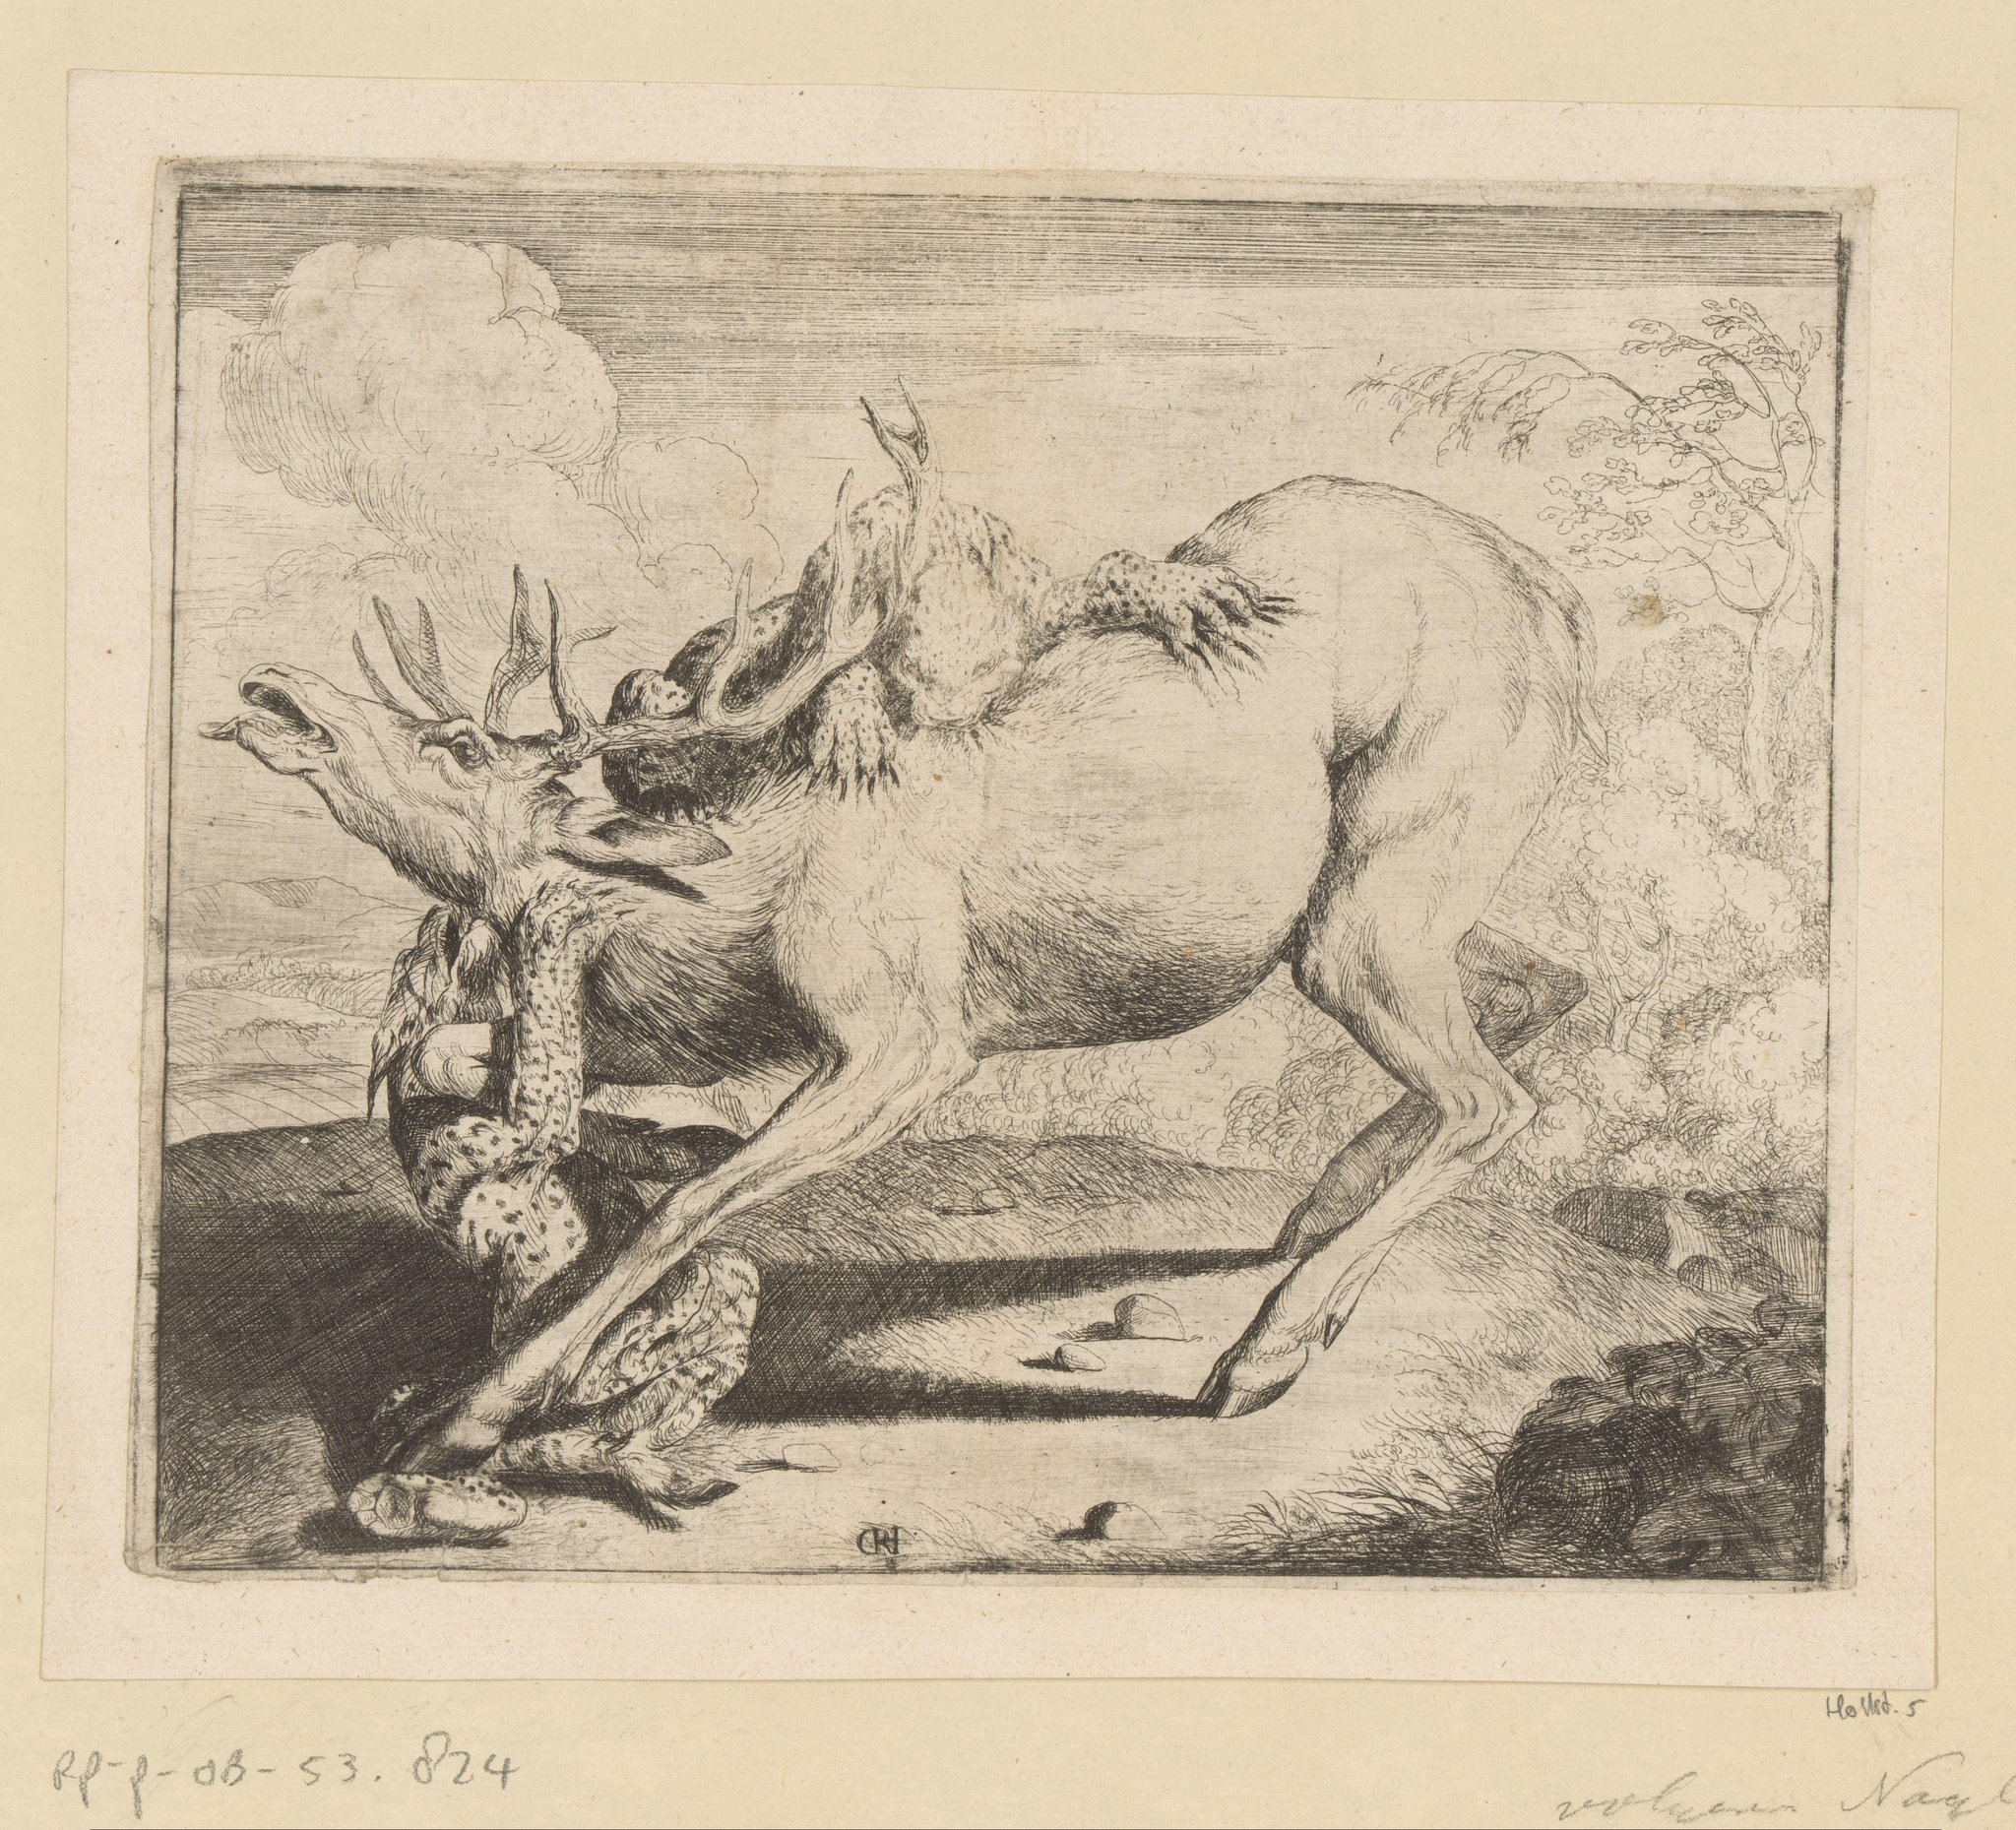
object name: print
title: Hert aangevallen door luipaarden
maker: carl borromäus andreas ruthart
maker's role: print maker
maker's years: 1630-1703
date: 1640-1703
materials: paper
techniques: etching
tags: beasts of prey, predatory animals: leopard, hoofed animals: deer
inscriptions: collector's mark: Lugt 240